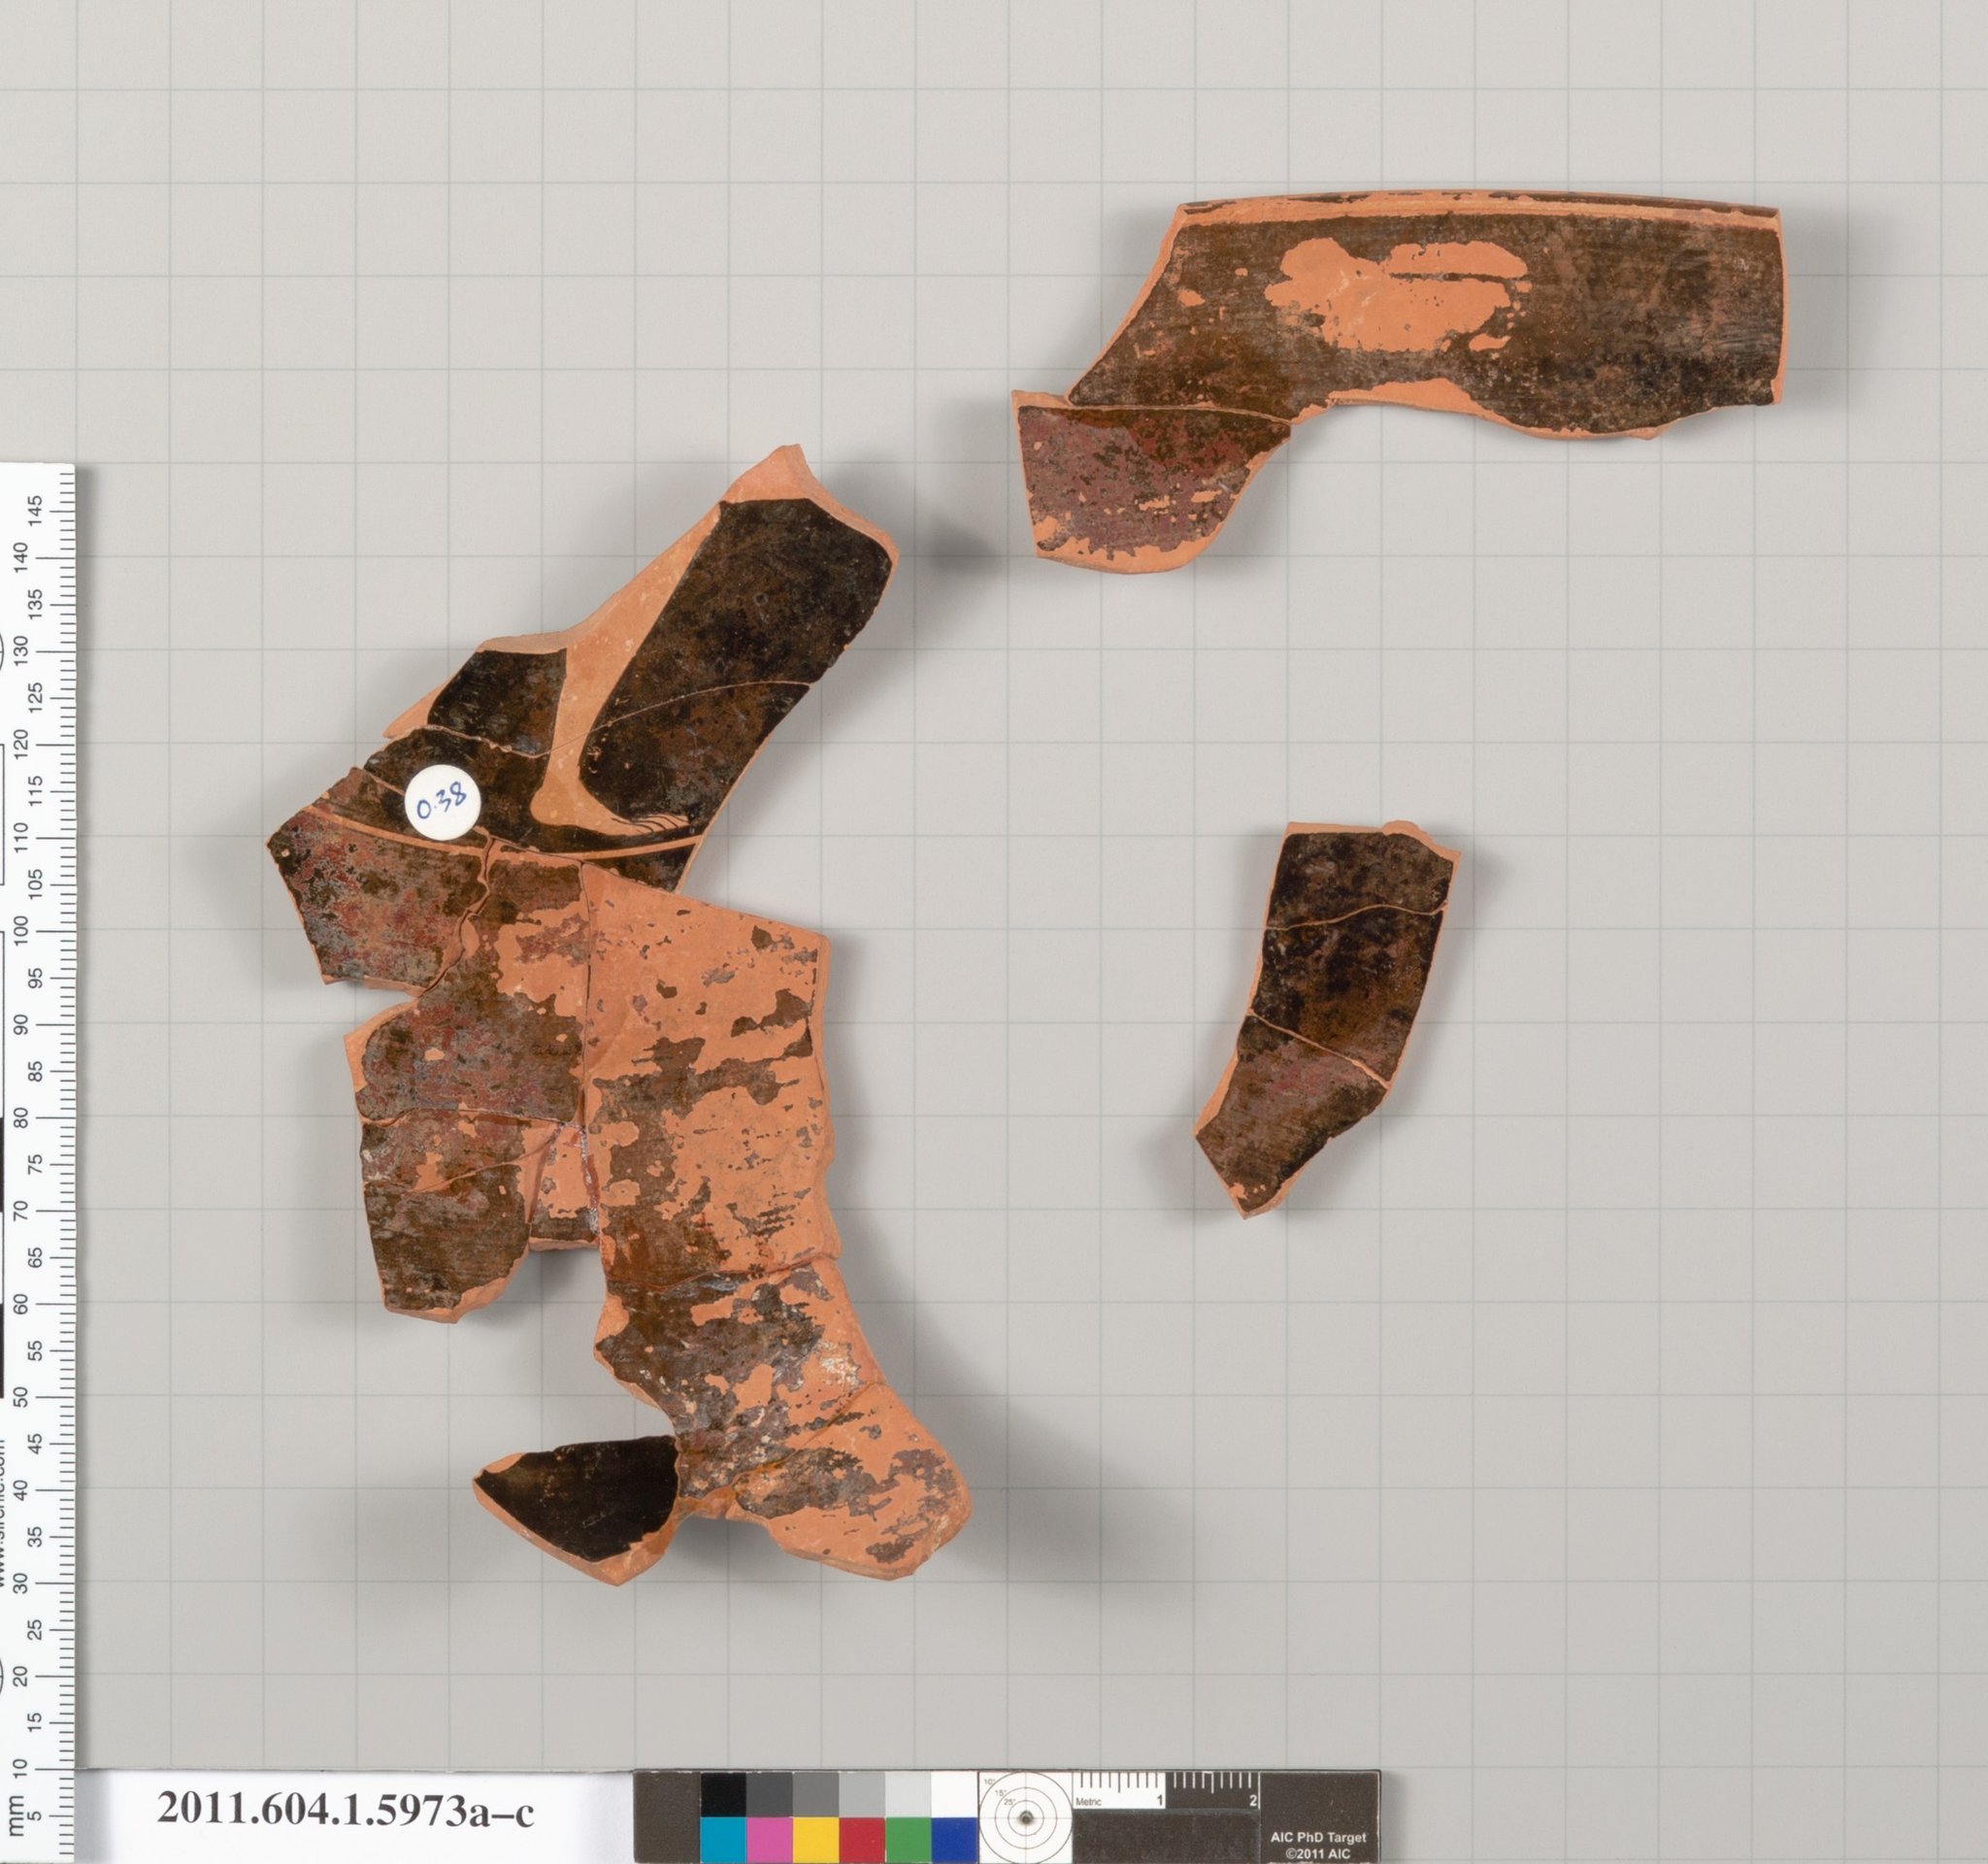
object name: kylix fragment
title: Terracotta fragments of a kylix (drinking cup)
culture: greek, attic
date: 433-567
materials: terracotta